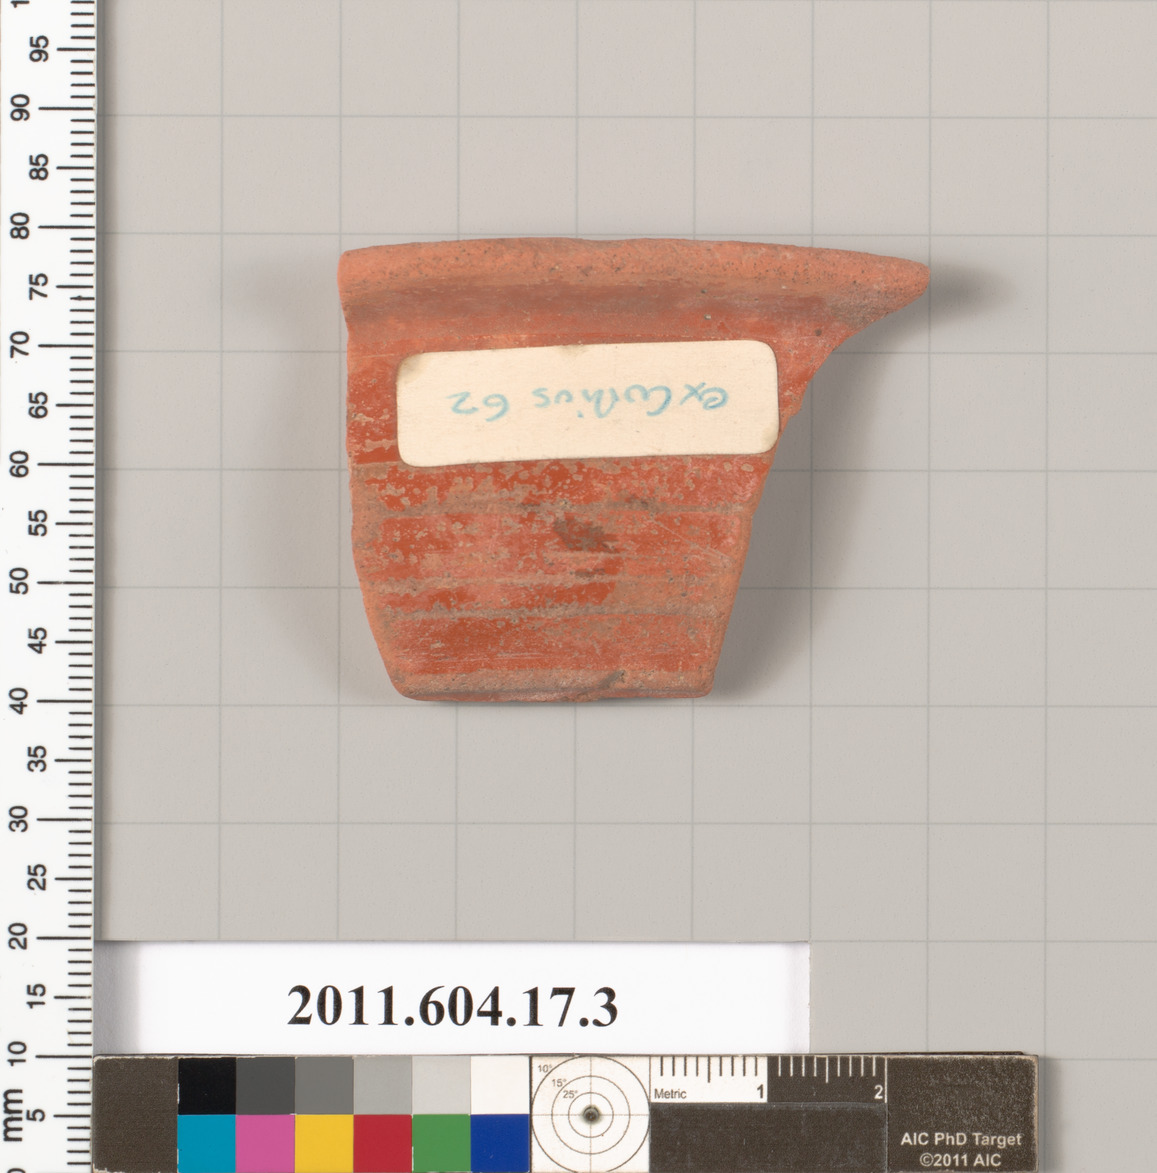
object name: fragment of a bowl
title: Terracotta rim fragment of a bowl?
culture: roman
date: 1-200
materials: terracotta